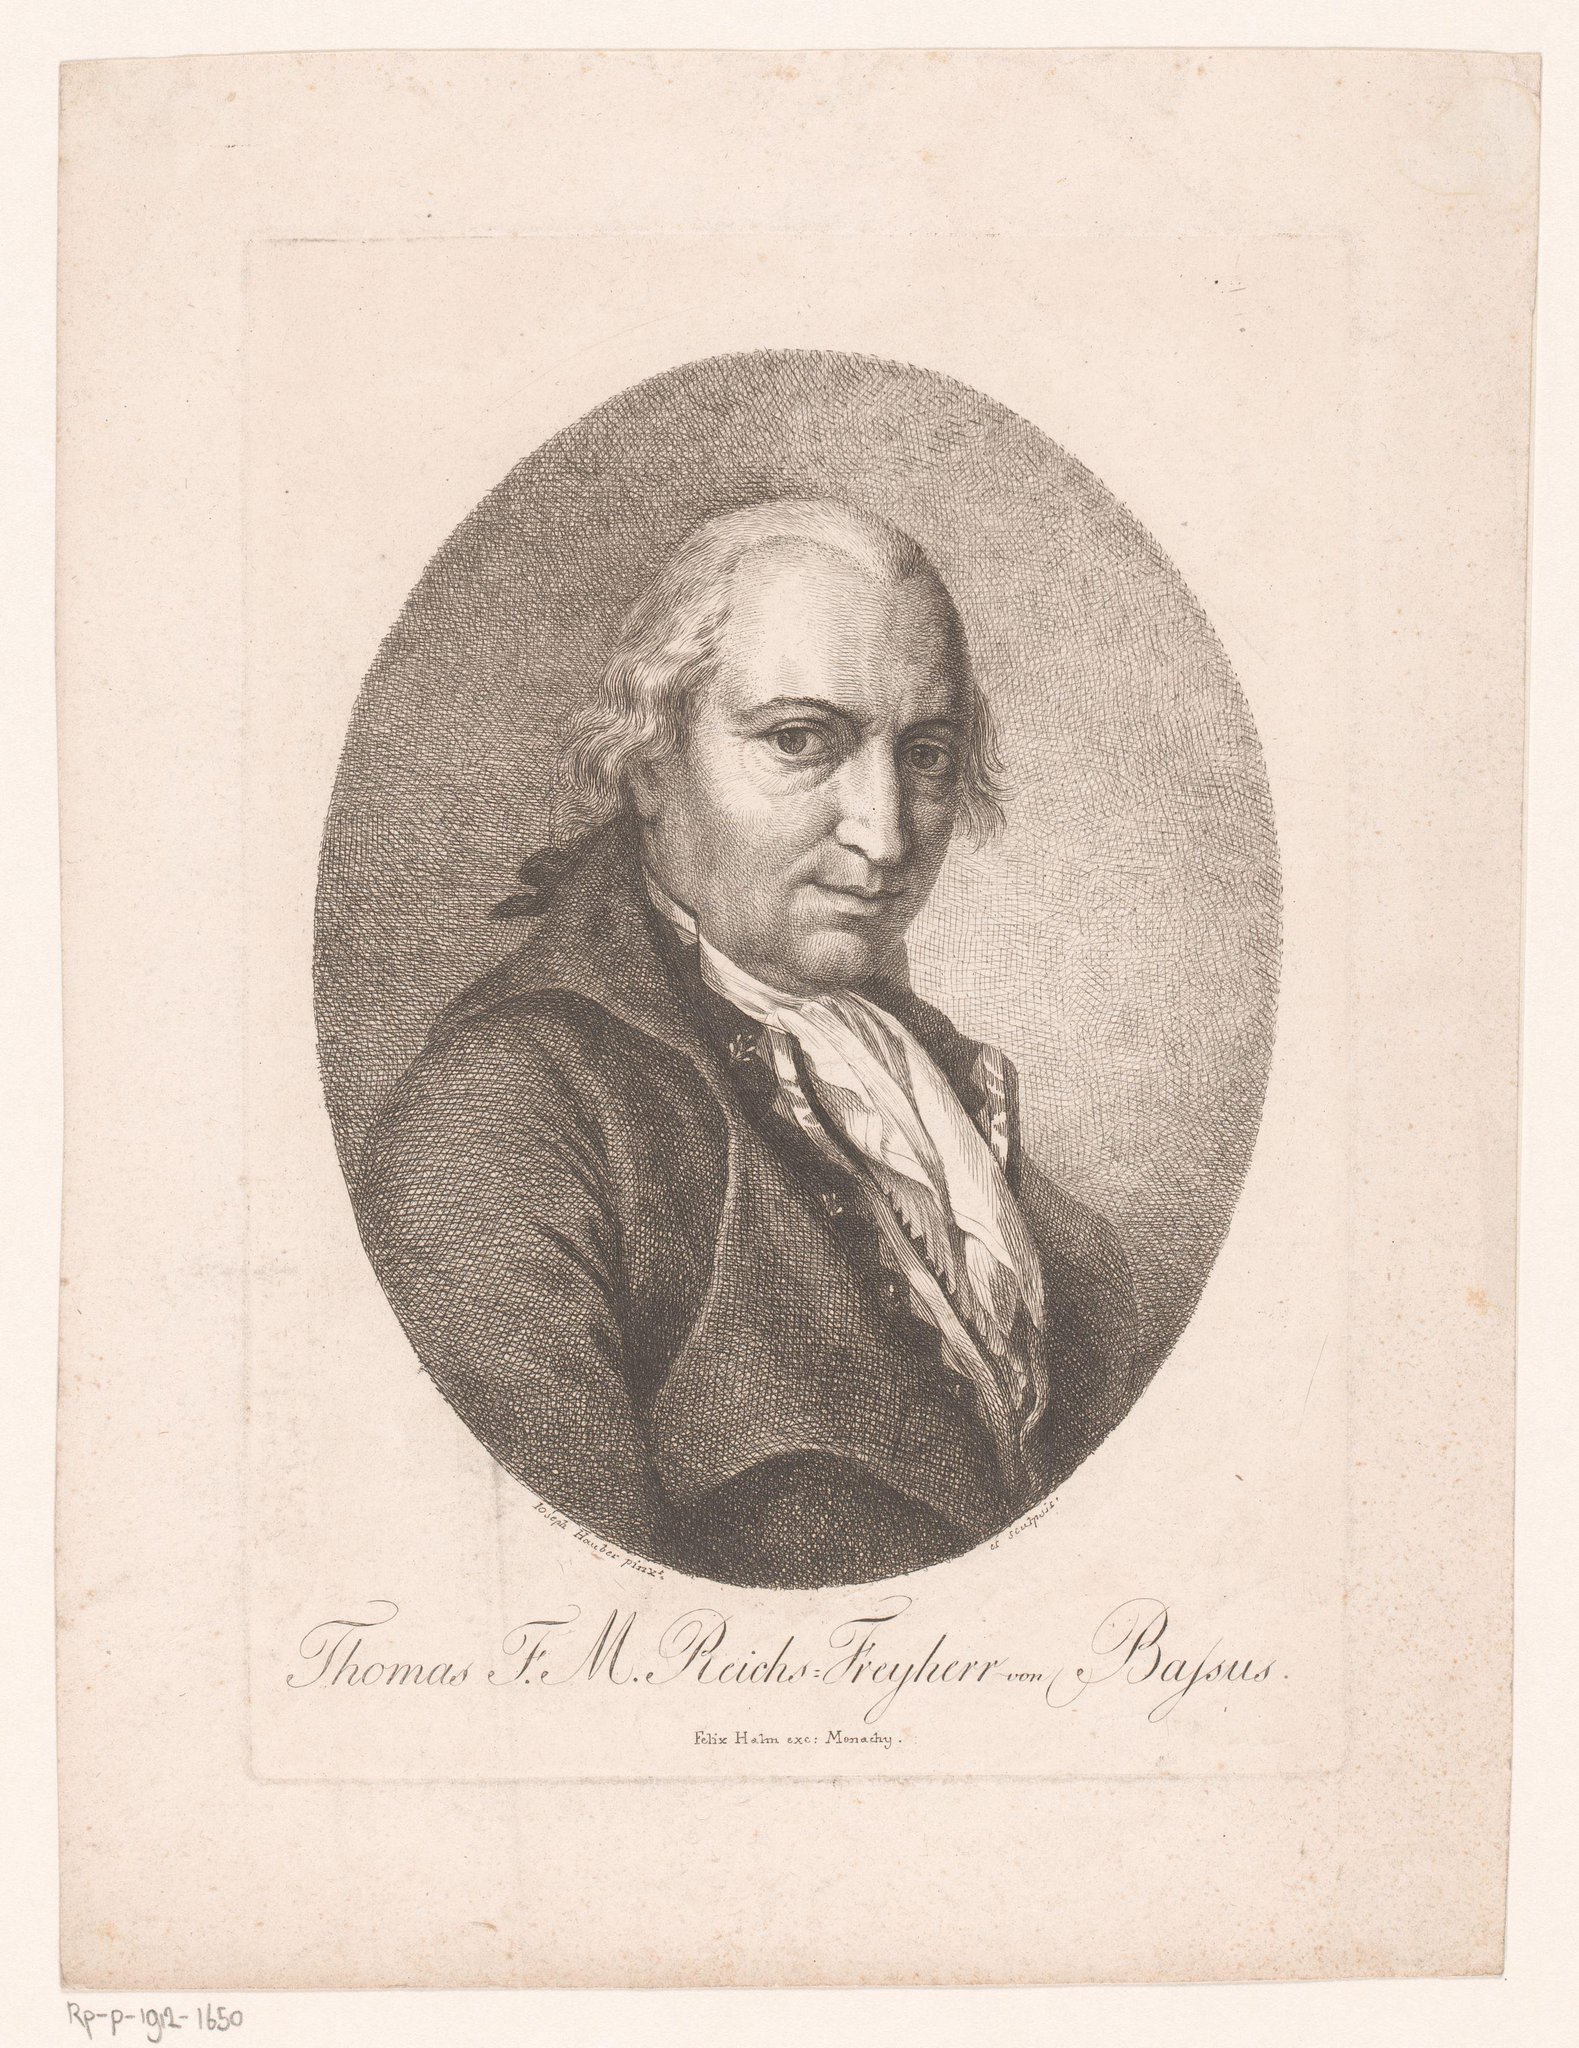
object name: print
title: Portret van Thomas von Bassus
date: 1776-1810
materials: paper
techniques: etching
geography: munich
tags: historical persons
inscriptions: collector's mark: Lugt 2228